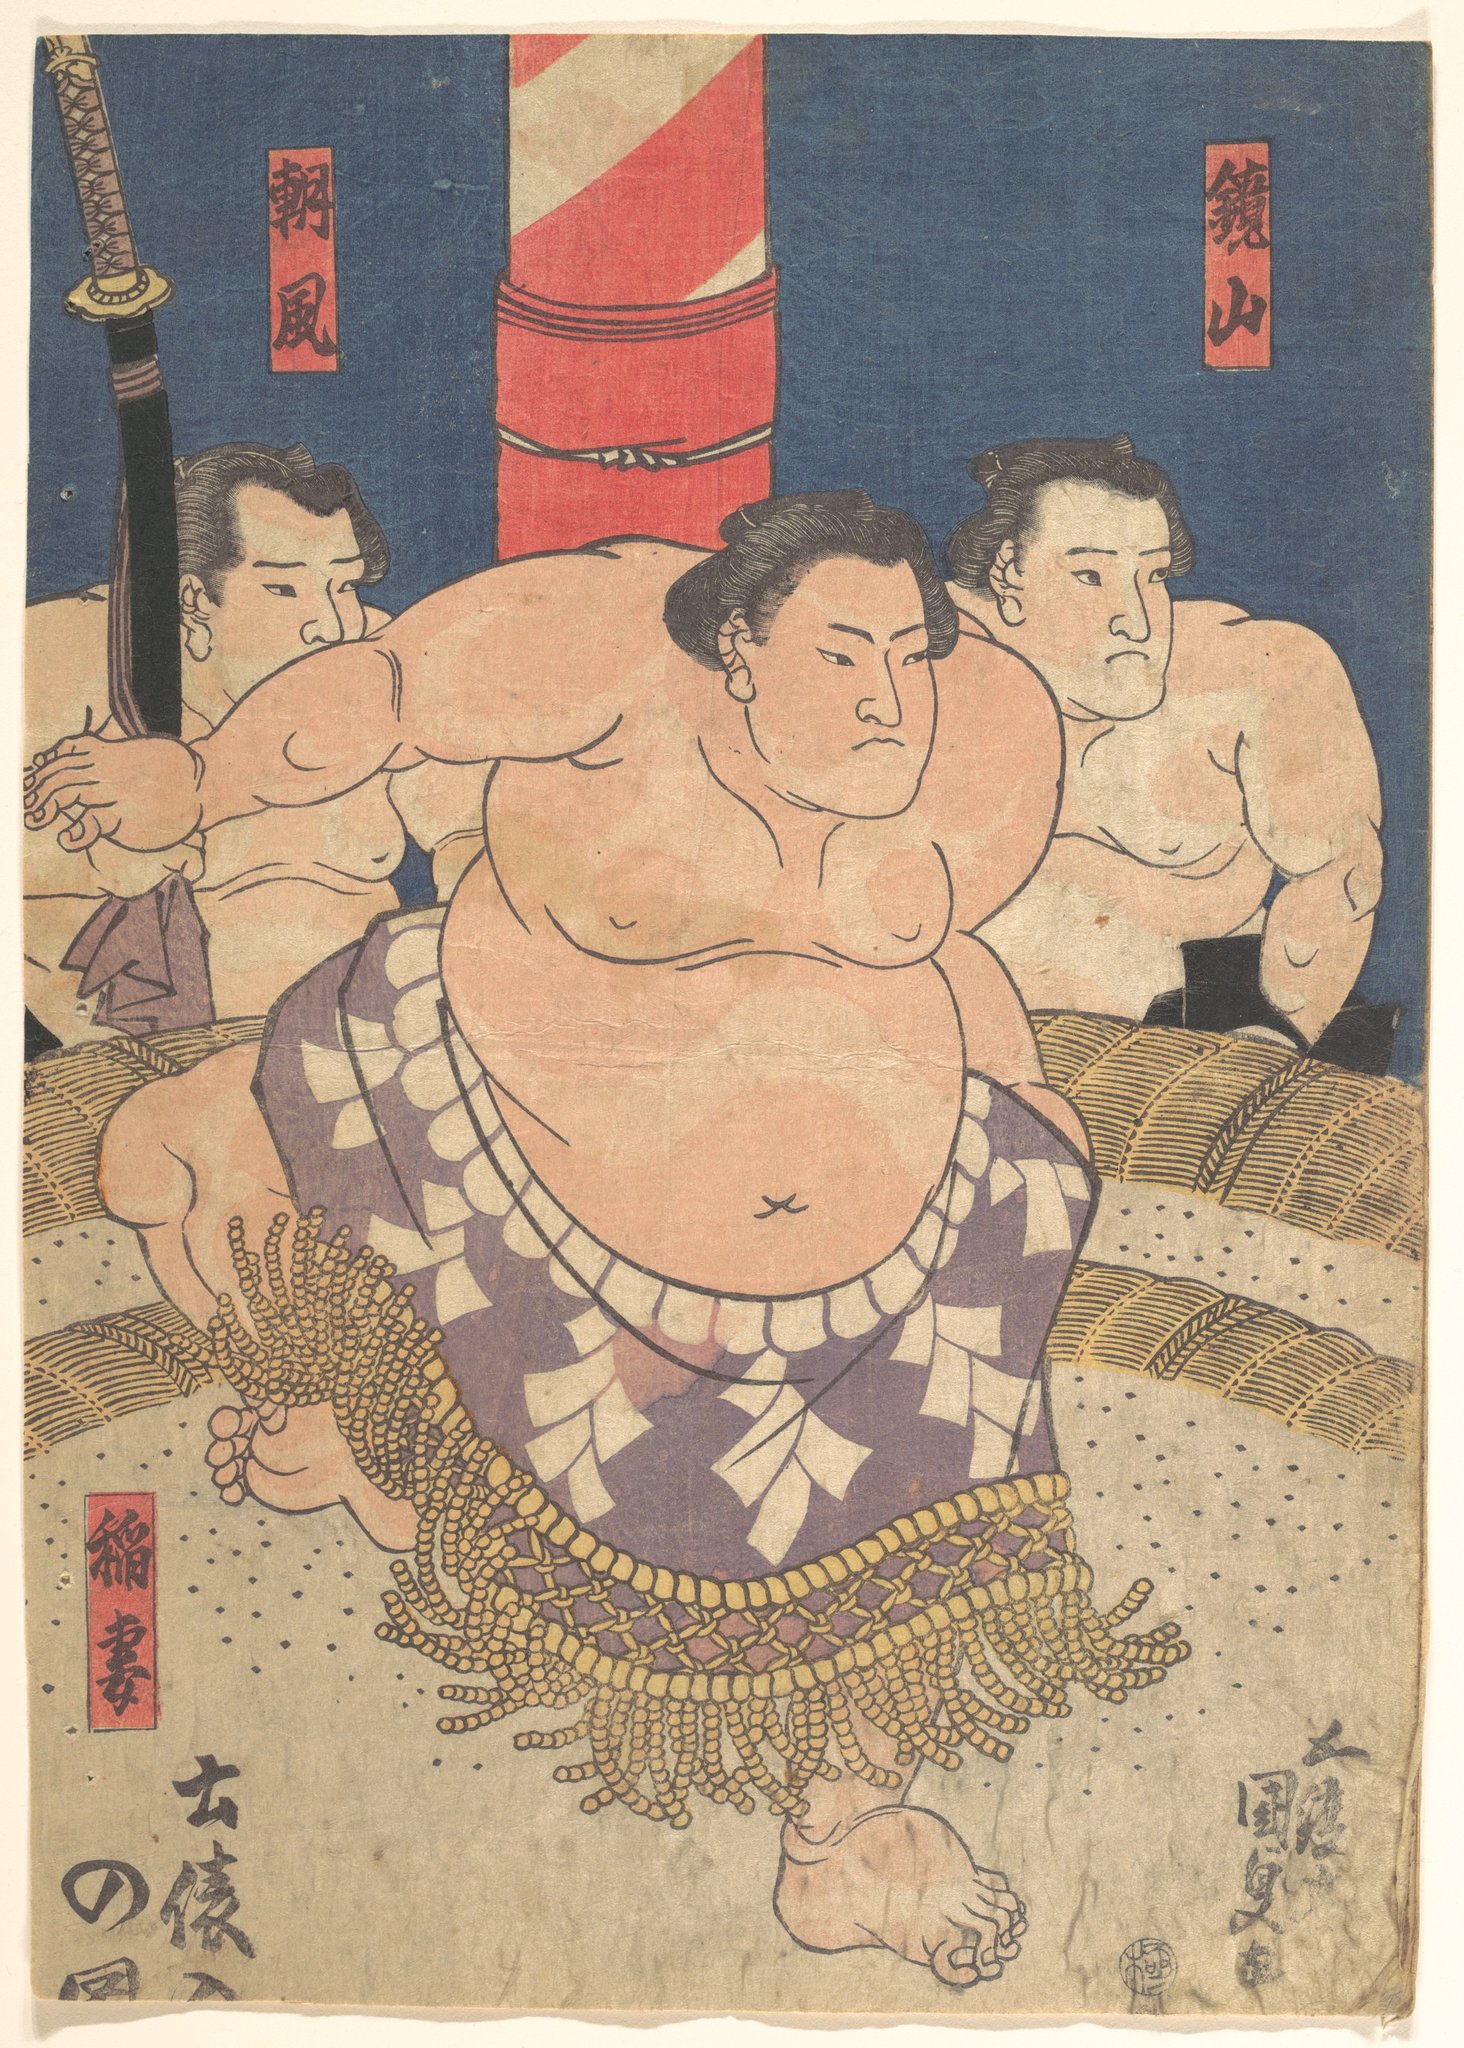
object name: print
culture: japanese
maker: utagawa kunisada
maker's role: artist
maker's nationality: japanese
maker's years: 1786-1864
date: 1801-1900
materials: ink, paper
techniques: woodblock print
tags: men